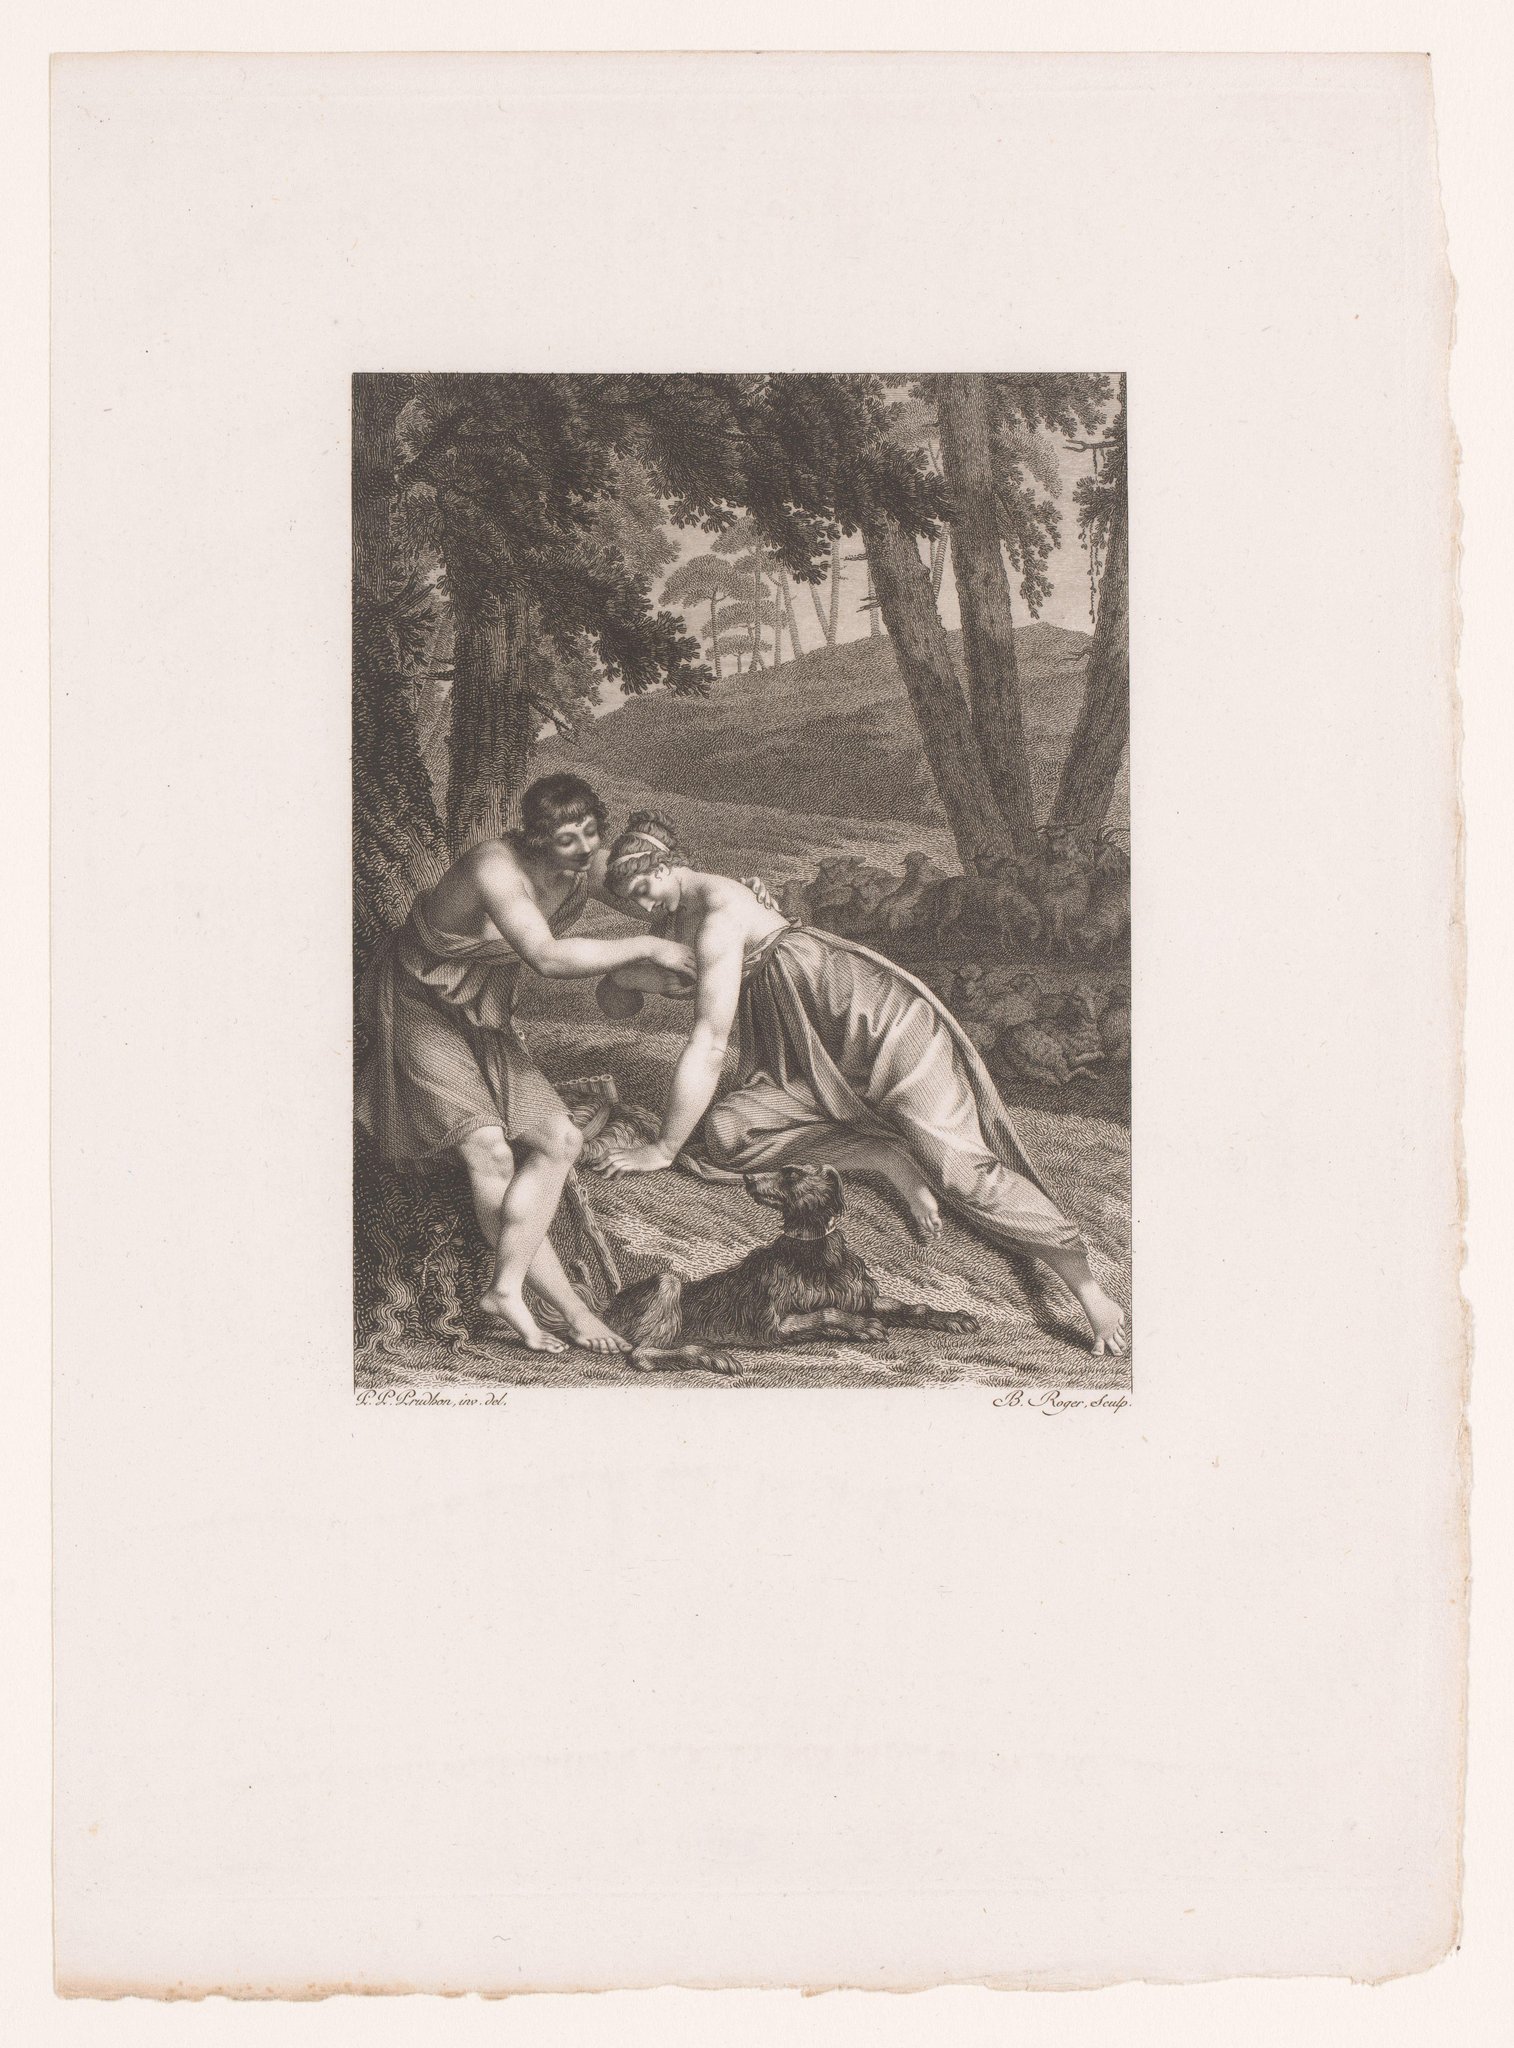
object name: print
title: Daphnis haalt een krekel uit Chloë's jurk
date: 1800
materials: paper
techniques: etching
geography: paris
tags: daphnis (in greek mythology a shepherd who invented pastoral poetry, chloe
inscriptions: collector's mark: Lugt 2228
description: Prent uit: Amyot, Jacques. Les Amours pastorales de Daphnis et de Chloé (...). Parijs: François-Ambroise Didot, 1800.